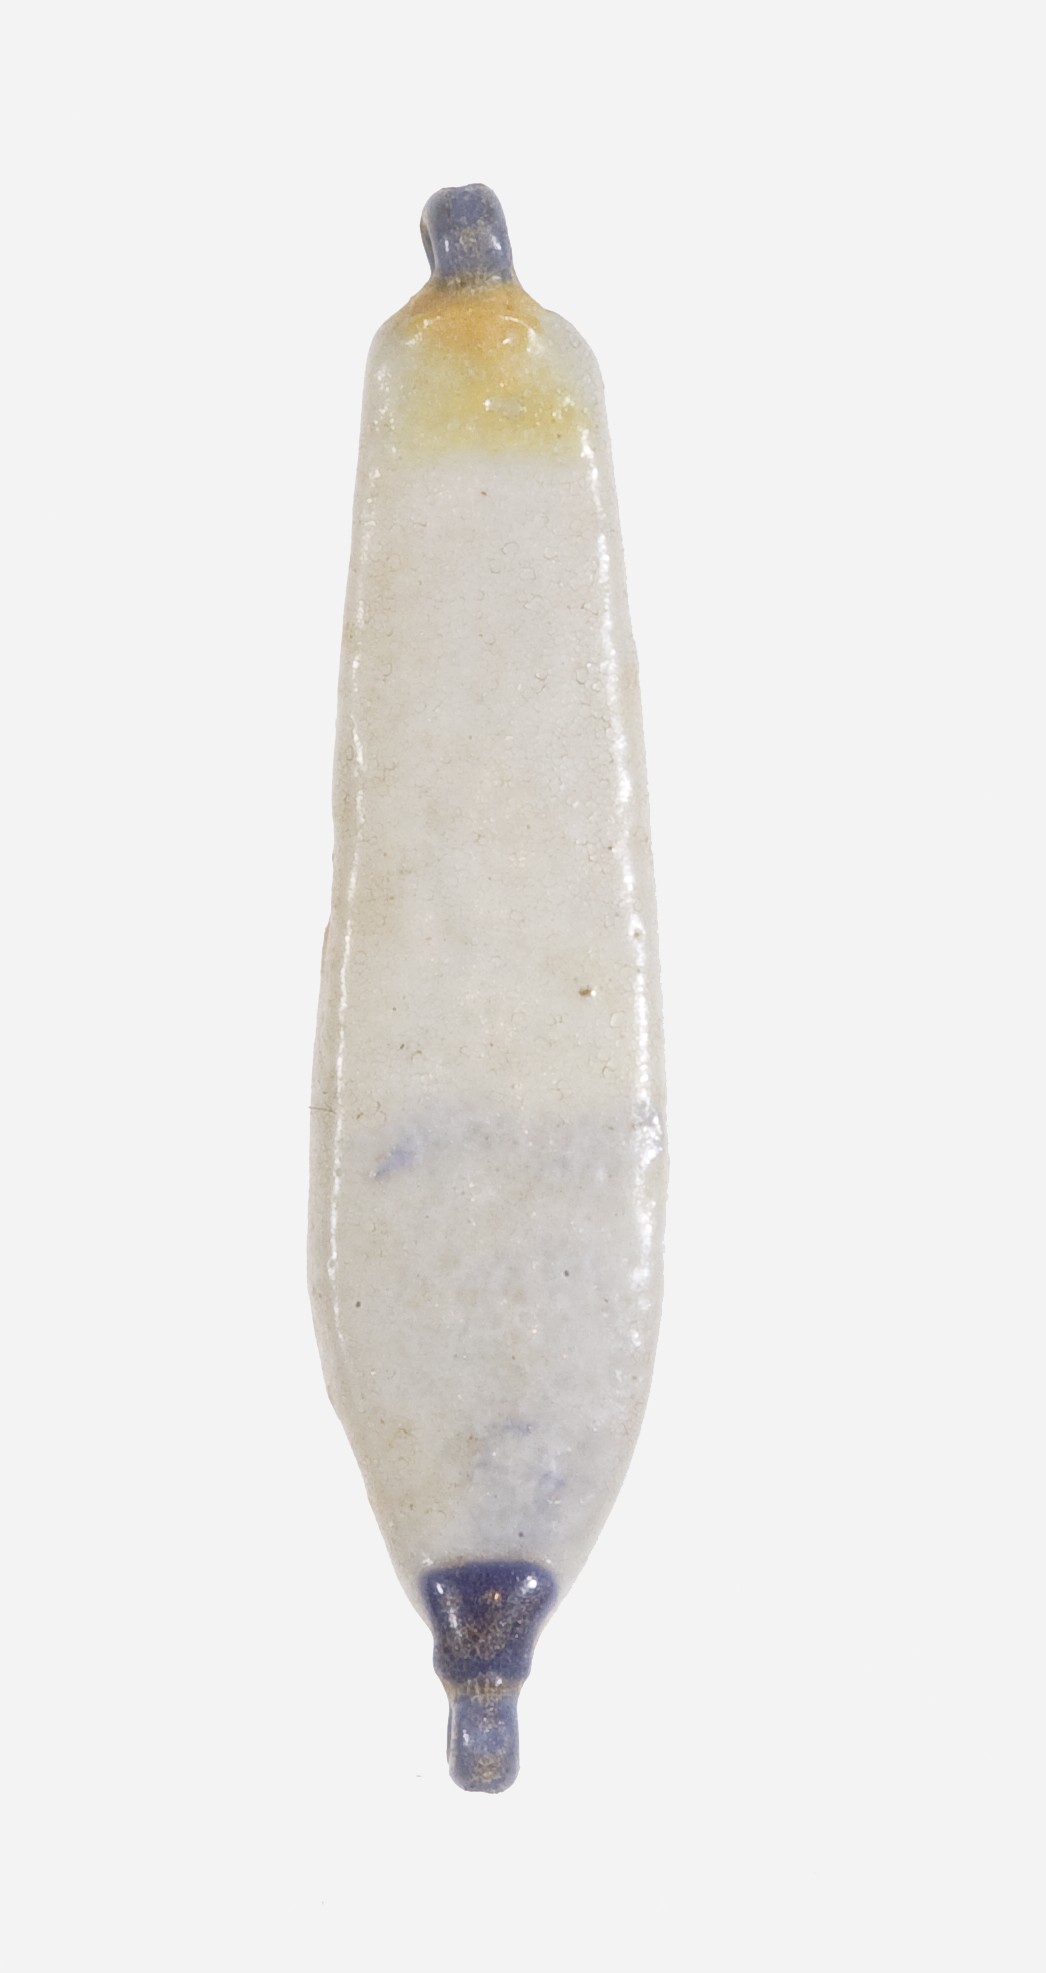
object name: bead, lotus petal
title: Bead in the Form of a Lotus Petal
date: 1390-1352 BCE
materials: faience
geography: egypt